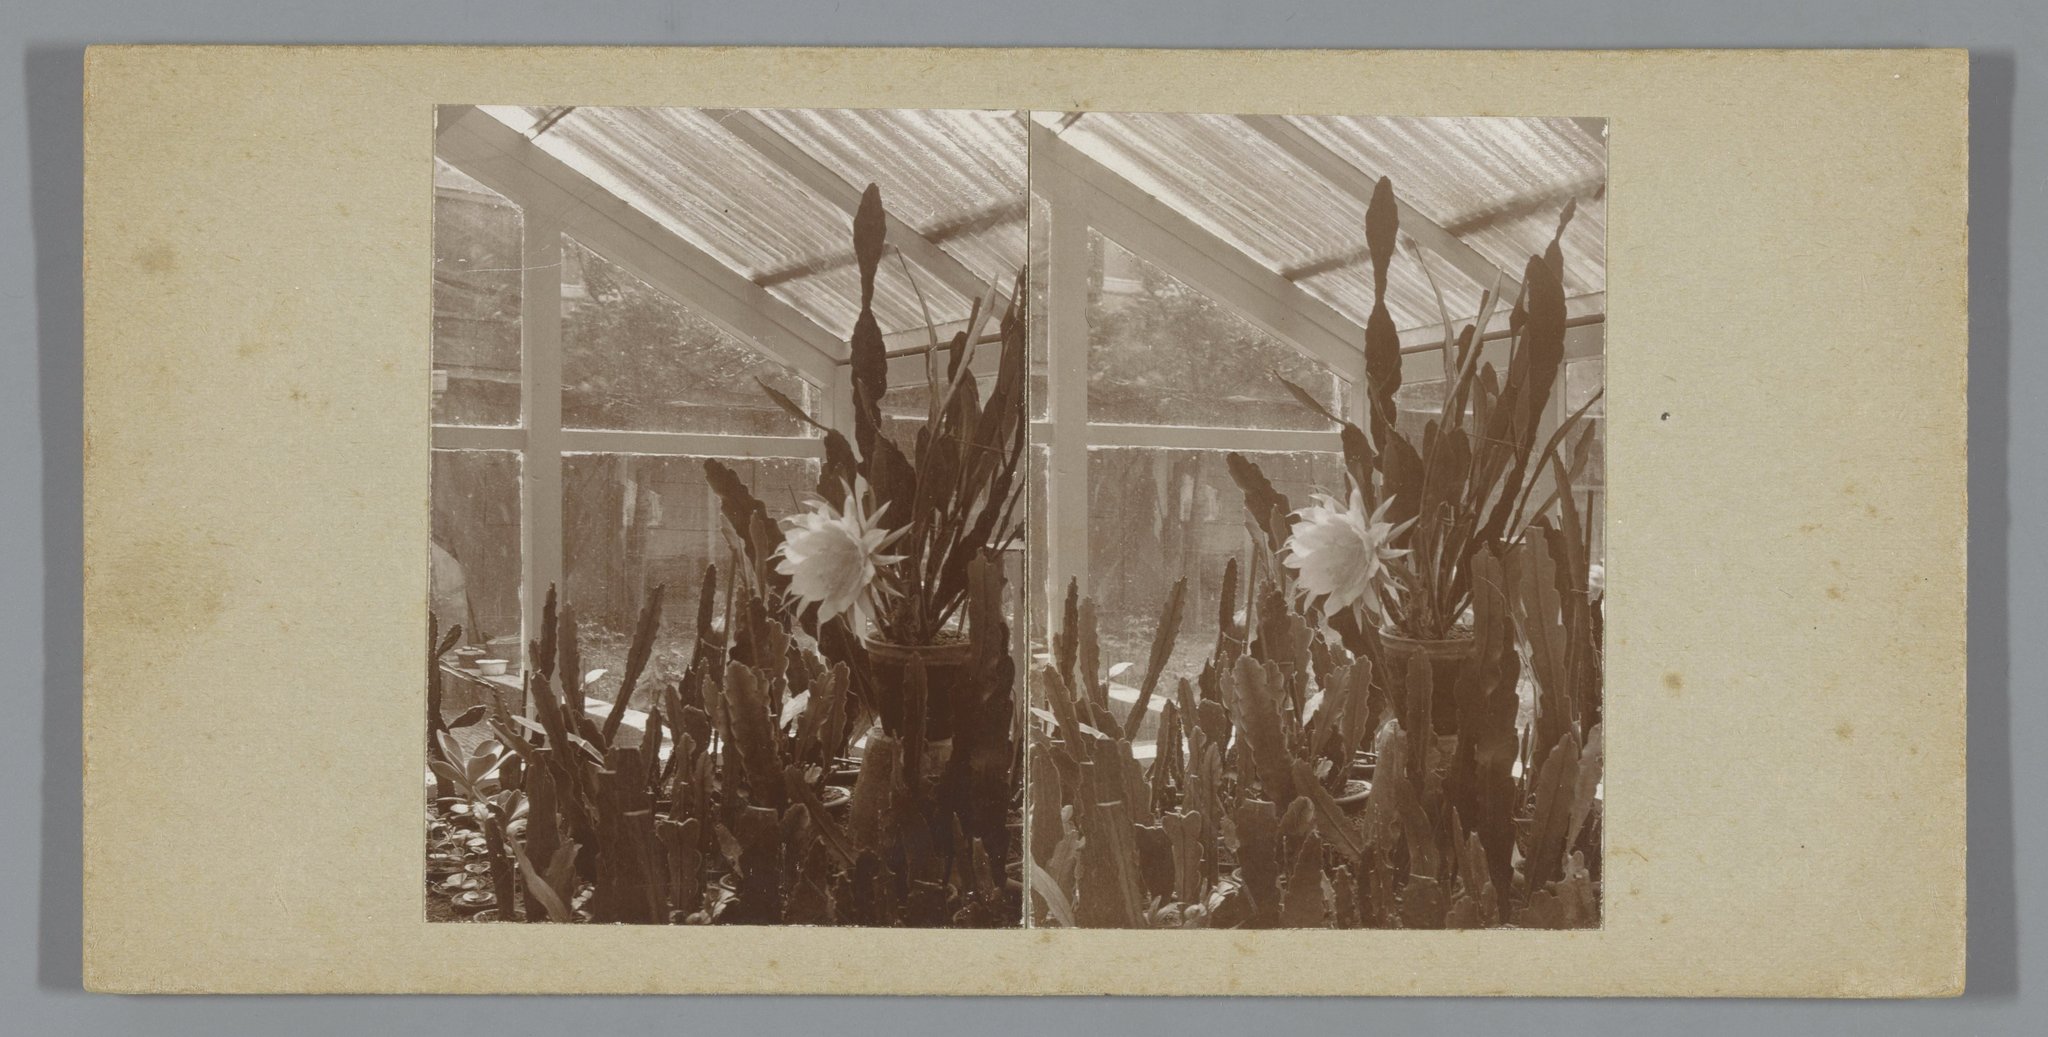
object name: stereograph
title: Bloeiende cactussen in een kas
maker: Anonymous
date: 1880-1940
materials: paper, cardboard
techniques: collodion silver print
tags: plants and herbs: cactus